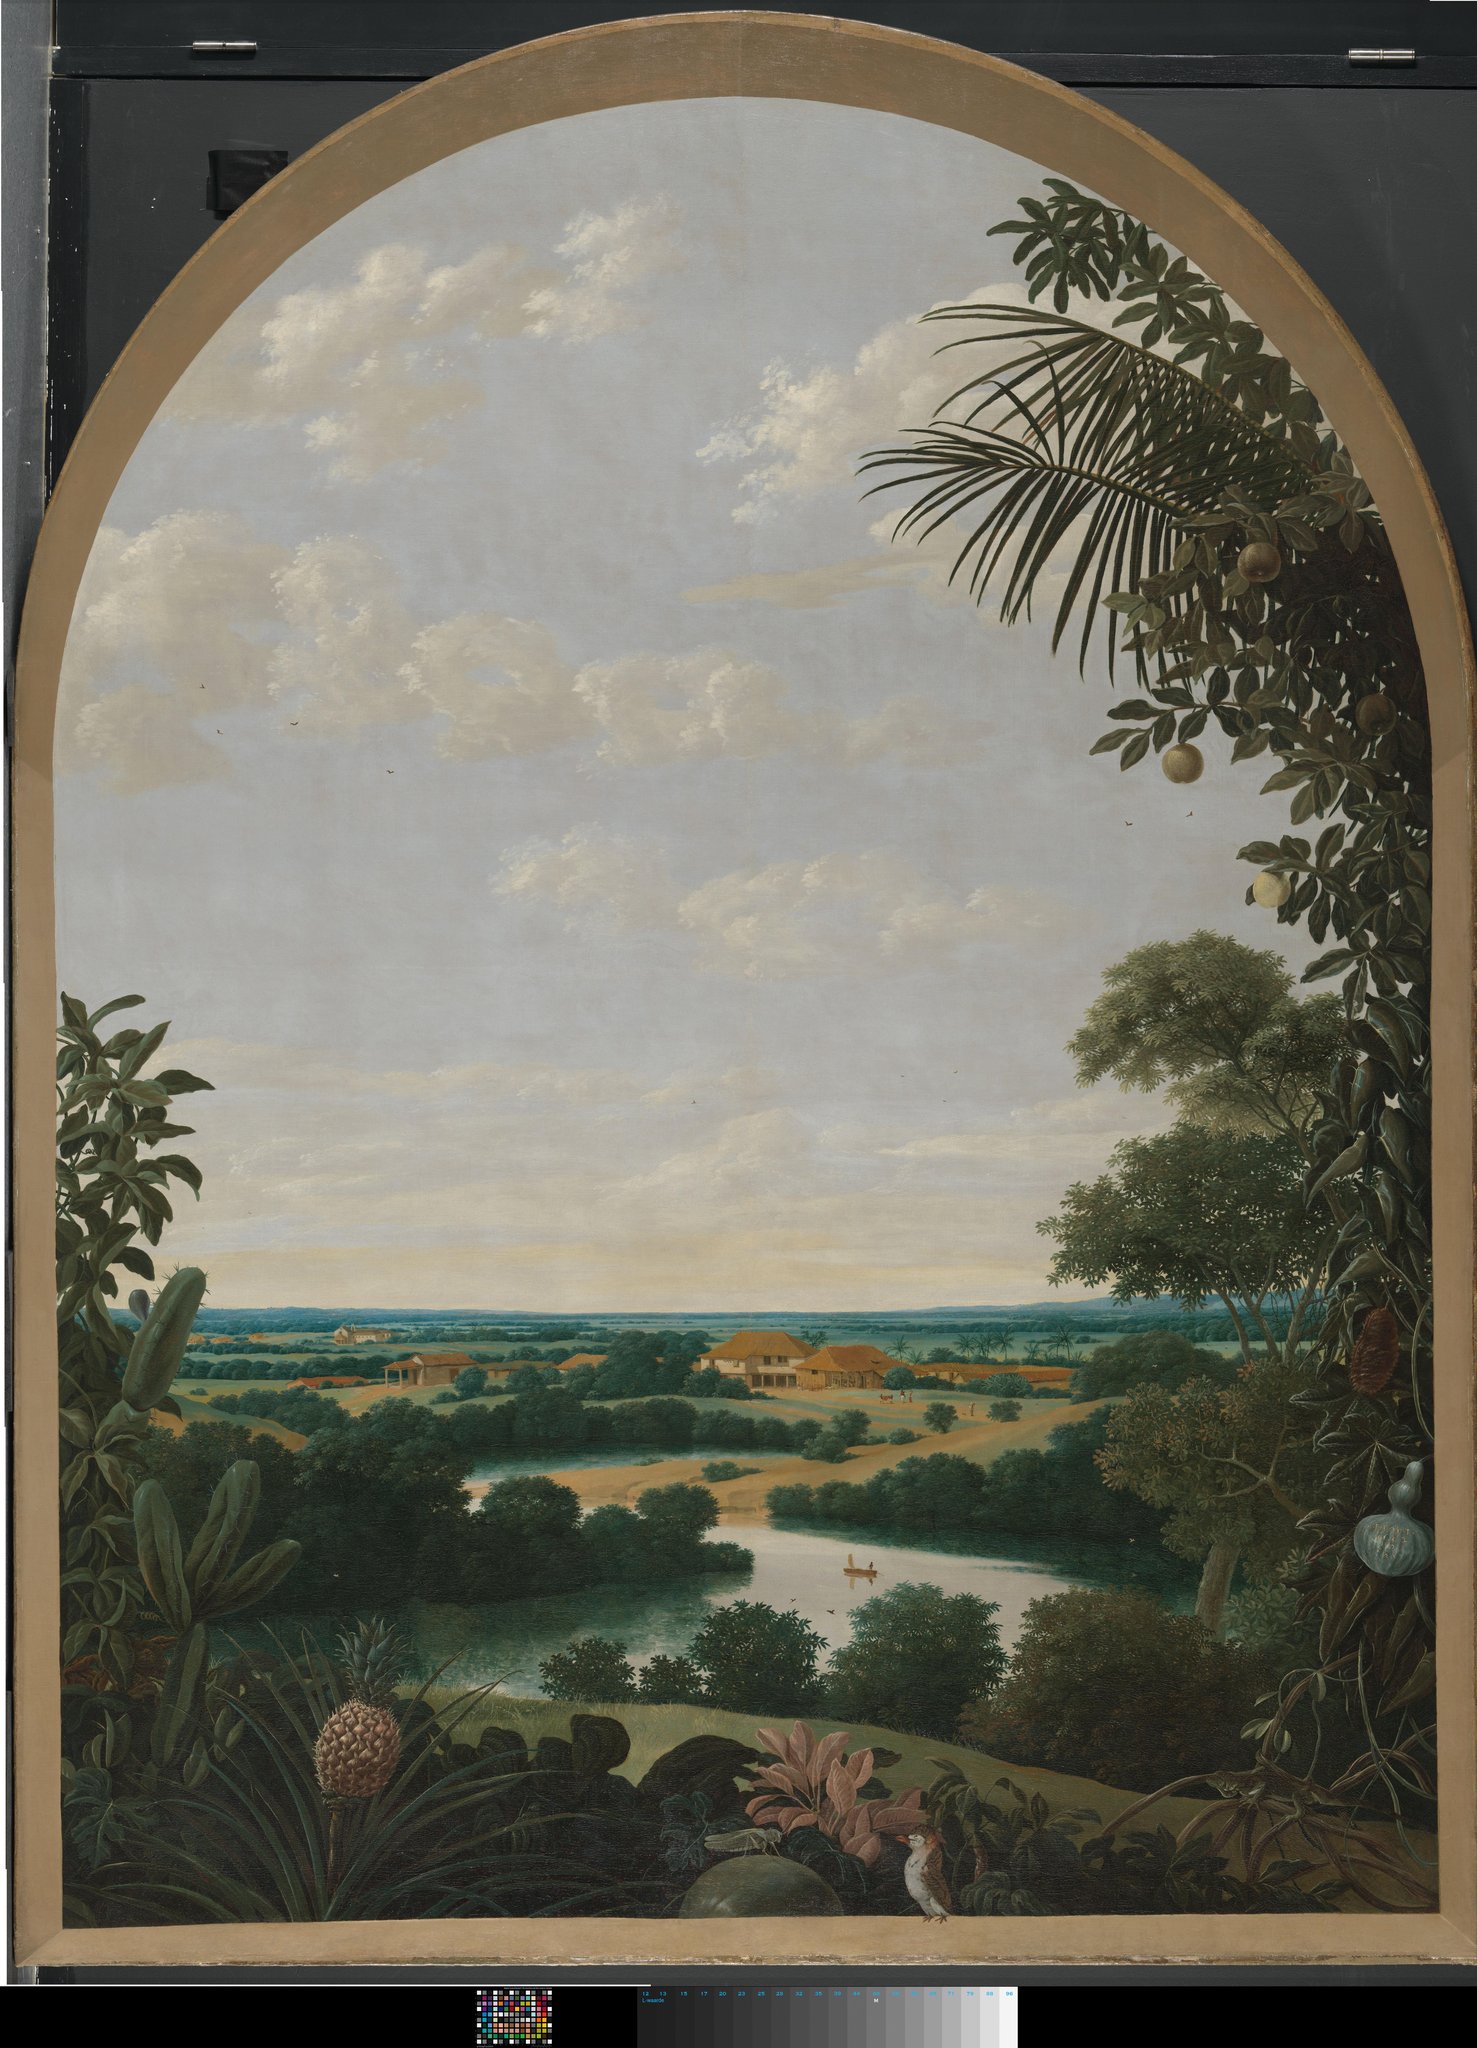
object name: painting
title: Landscape in Brazil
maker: frans jansz post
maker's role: painter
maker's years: 1612-1680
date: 1652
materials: canvas, oil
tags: plantation, landscapes in tropical and sub-tropical regions, brasil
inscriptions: signature and date: ‘F. Post 1652 12/22’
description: The Dutch West India Company seized the lucrative sugar industry from the Portuguese. Sugar cane was cultivated on plantations like the one depicted in this painting. A sugar mill can be seen in the centre, under the canopy. Violence was used to force people in slavery to do the work. What is portrayed as an idyll for the Dutch viewers was a gruesome reality for them.